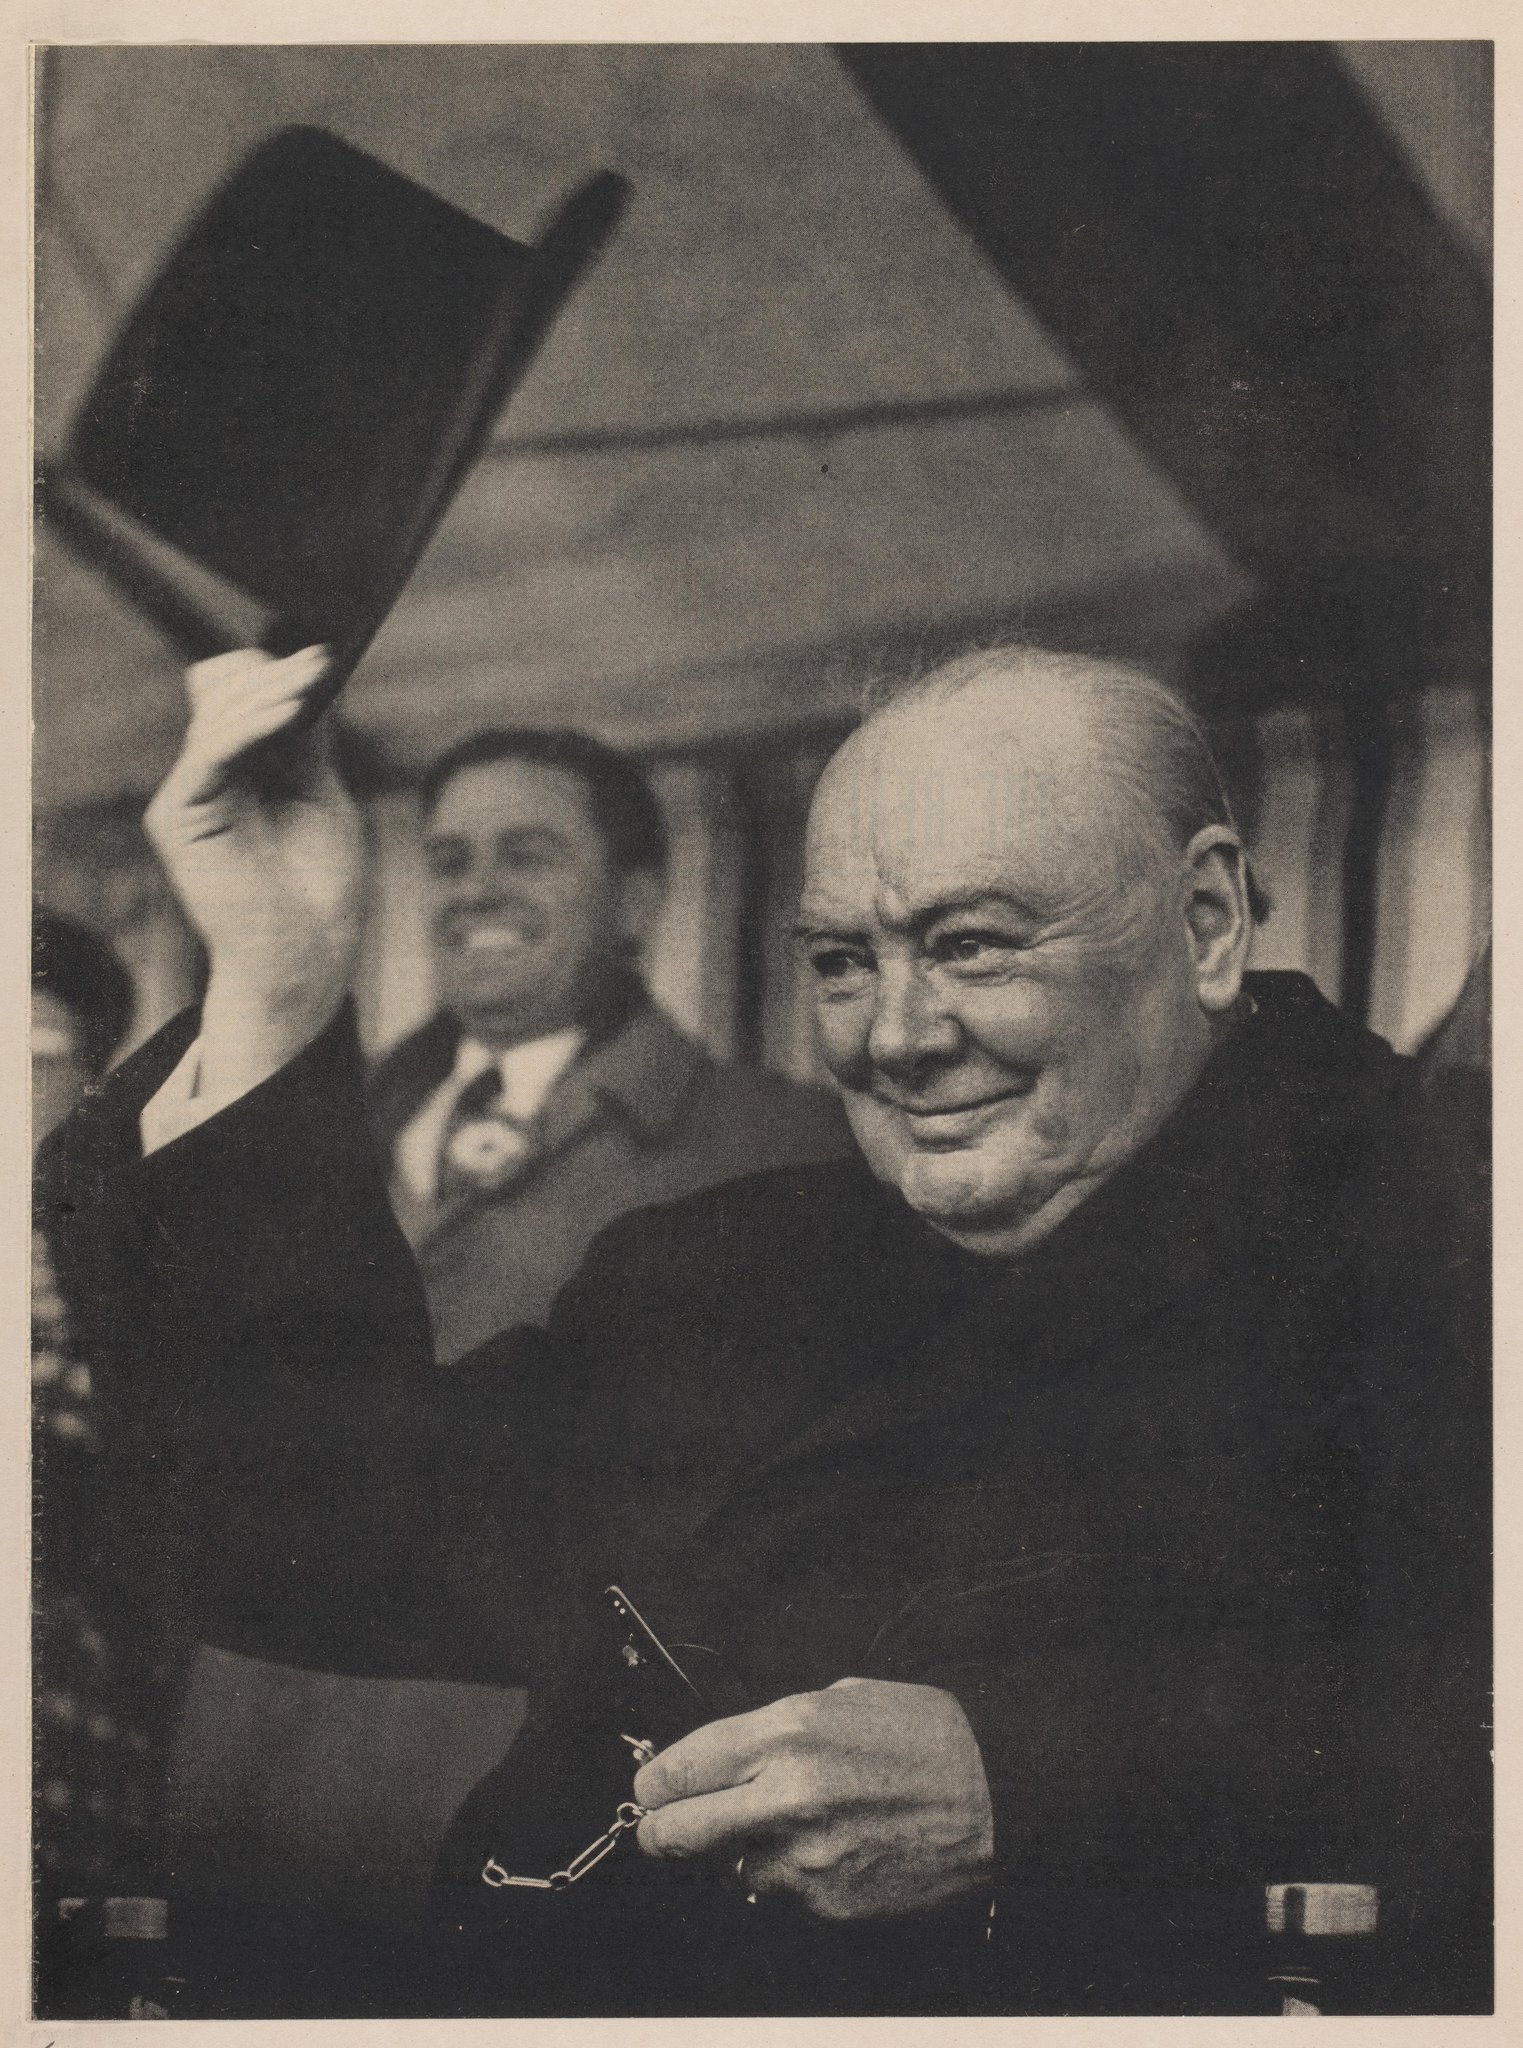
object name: photomechanical print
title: Portret van Winston Churchill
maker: Anonymous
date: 1940-1955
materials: paper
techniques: autotype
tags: london, historical persons, politician, e.g. party leader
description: Fotomechanisch portret van Winston Churchill, vermoedelijk afkomstig uit een tijdschrift.